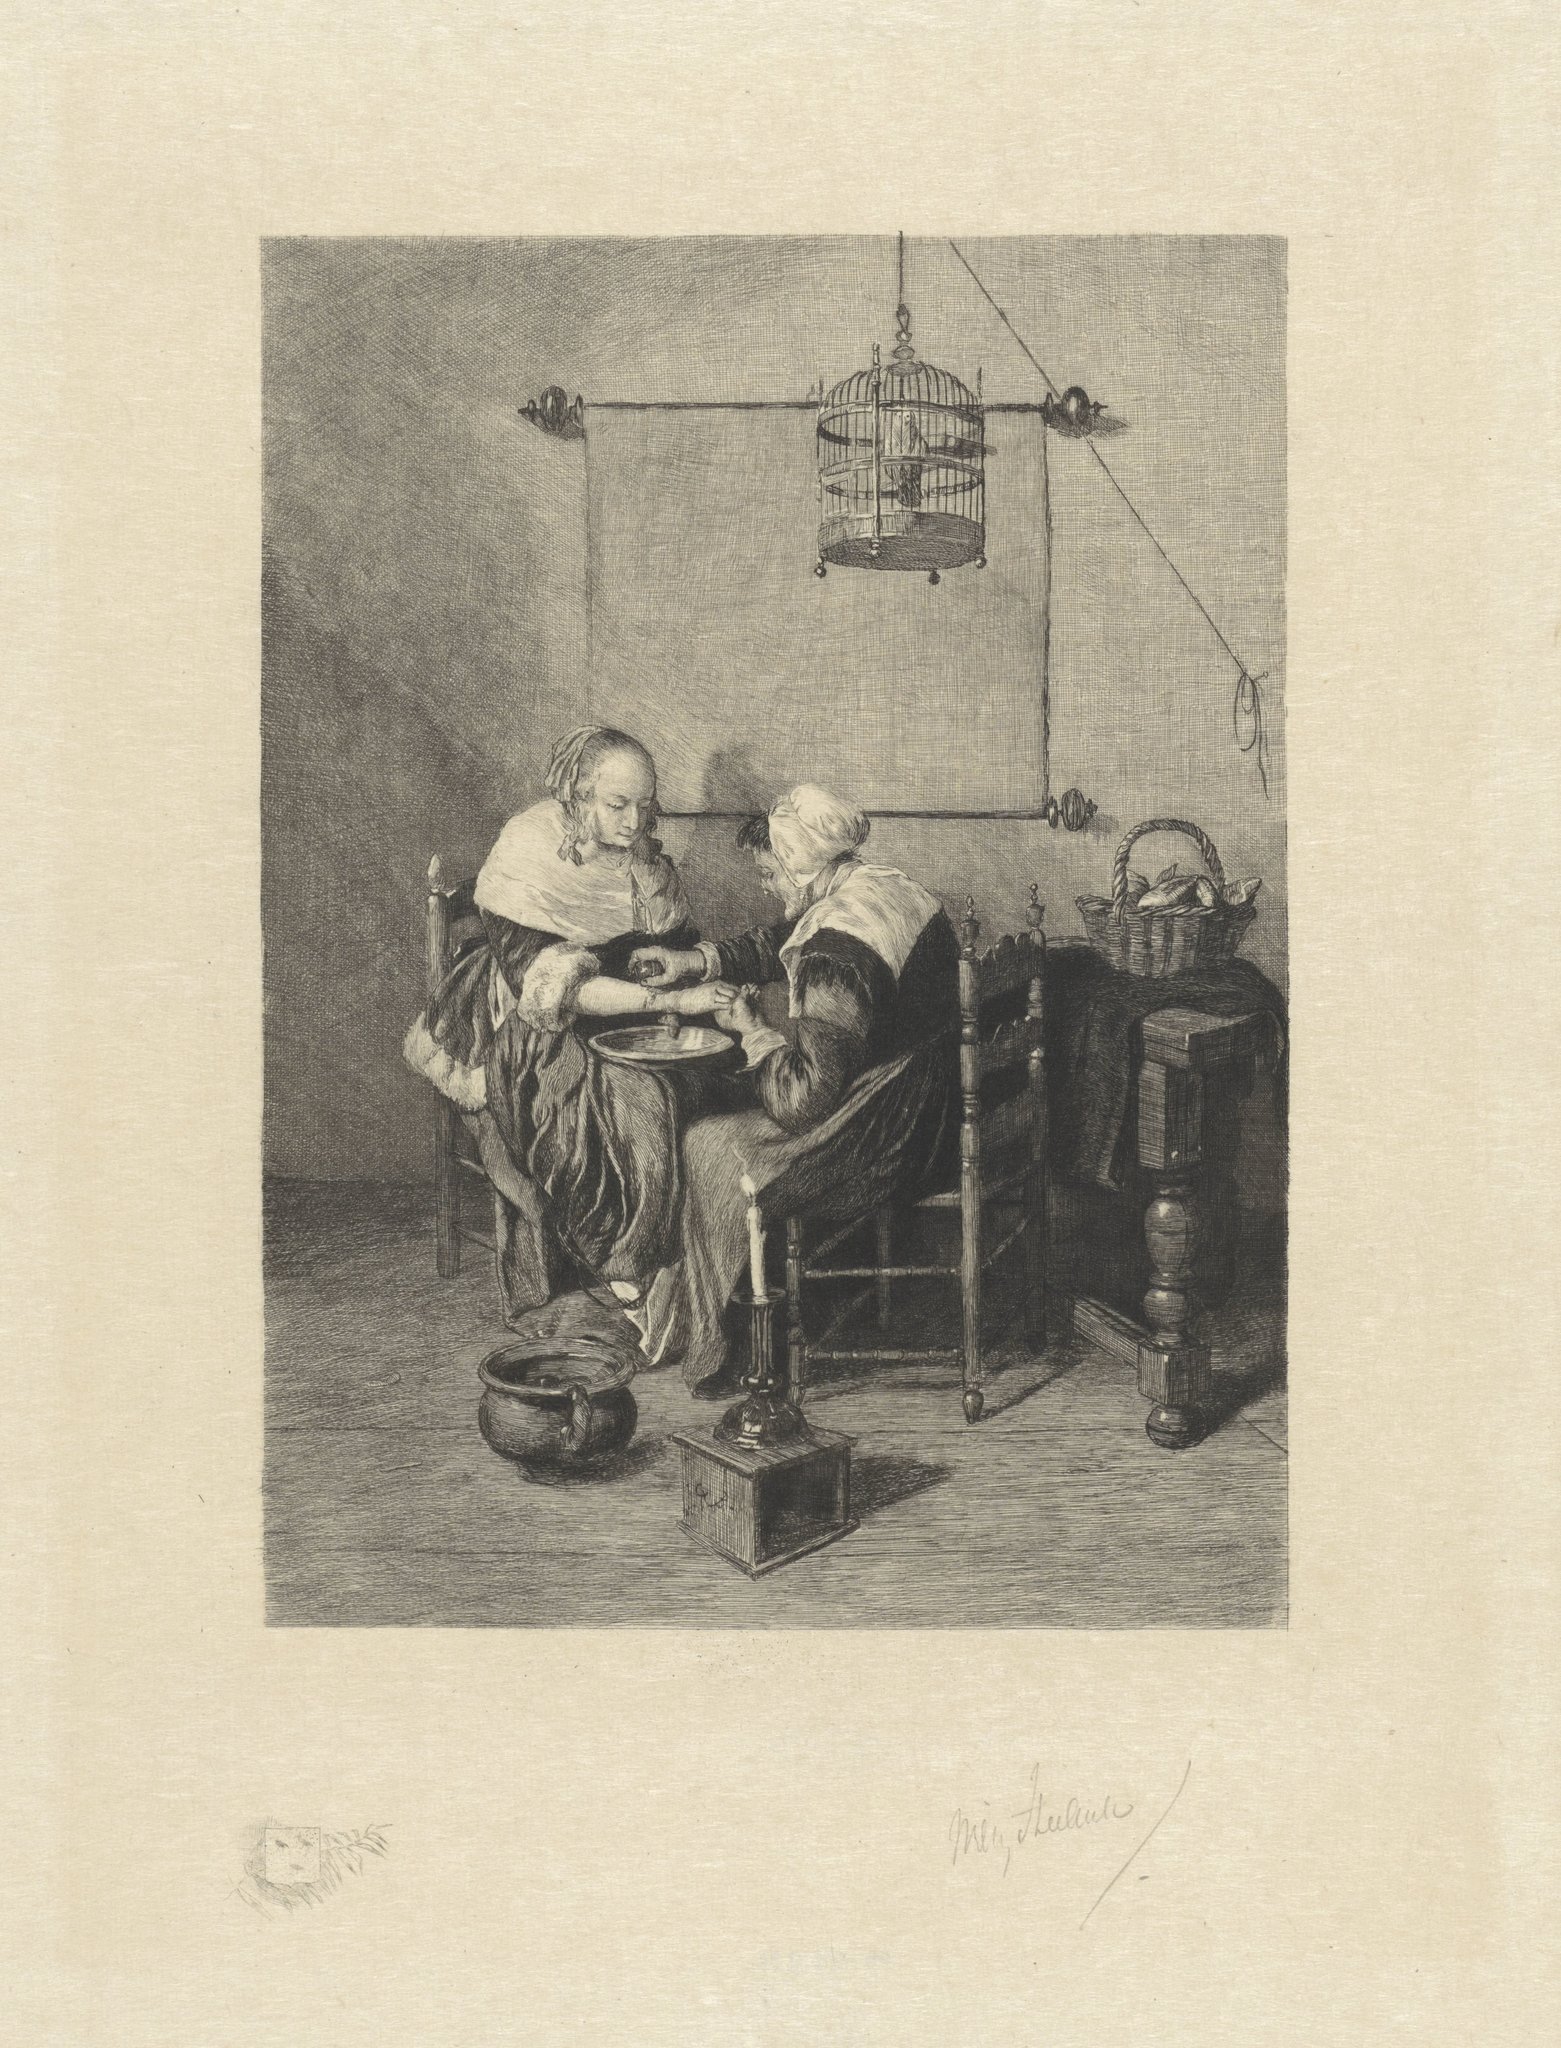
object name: print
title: Een oude vrouw die een aderlating uitvoert, bekend als 'De kopster'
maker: willem steelink (ii)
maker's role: draughtsman, print maker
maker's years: 1856-1928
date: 1888-1891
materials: paper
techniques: etching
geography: netherlands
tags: bleeding, blood-letting, e.g.: with the aid of cupping-glasses, candle, bird in a cage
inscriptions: collector's mark: Lugt 2228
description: Prent mogelijk gebruikt in: Oude kunst in Nederland : etsen van Wilm. Steelink, naar schilderijen uit de kabinetten van A. Bredius, A.J. Enschedé, J.P. Six, P.H. Siz, H.A. Steengracht van Duivenvoorde, Victor de Stuers en andere verzamelingen. Amsterdam: Van Holkema & Warendorf, 1888-1891.